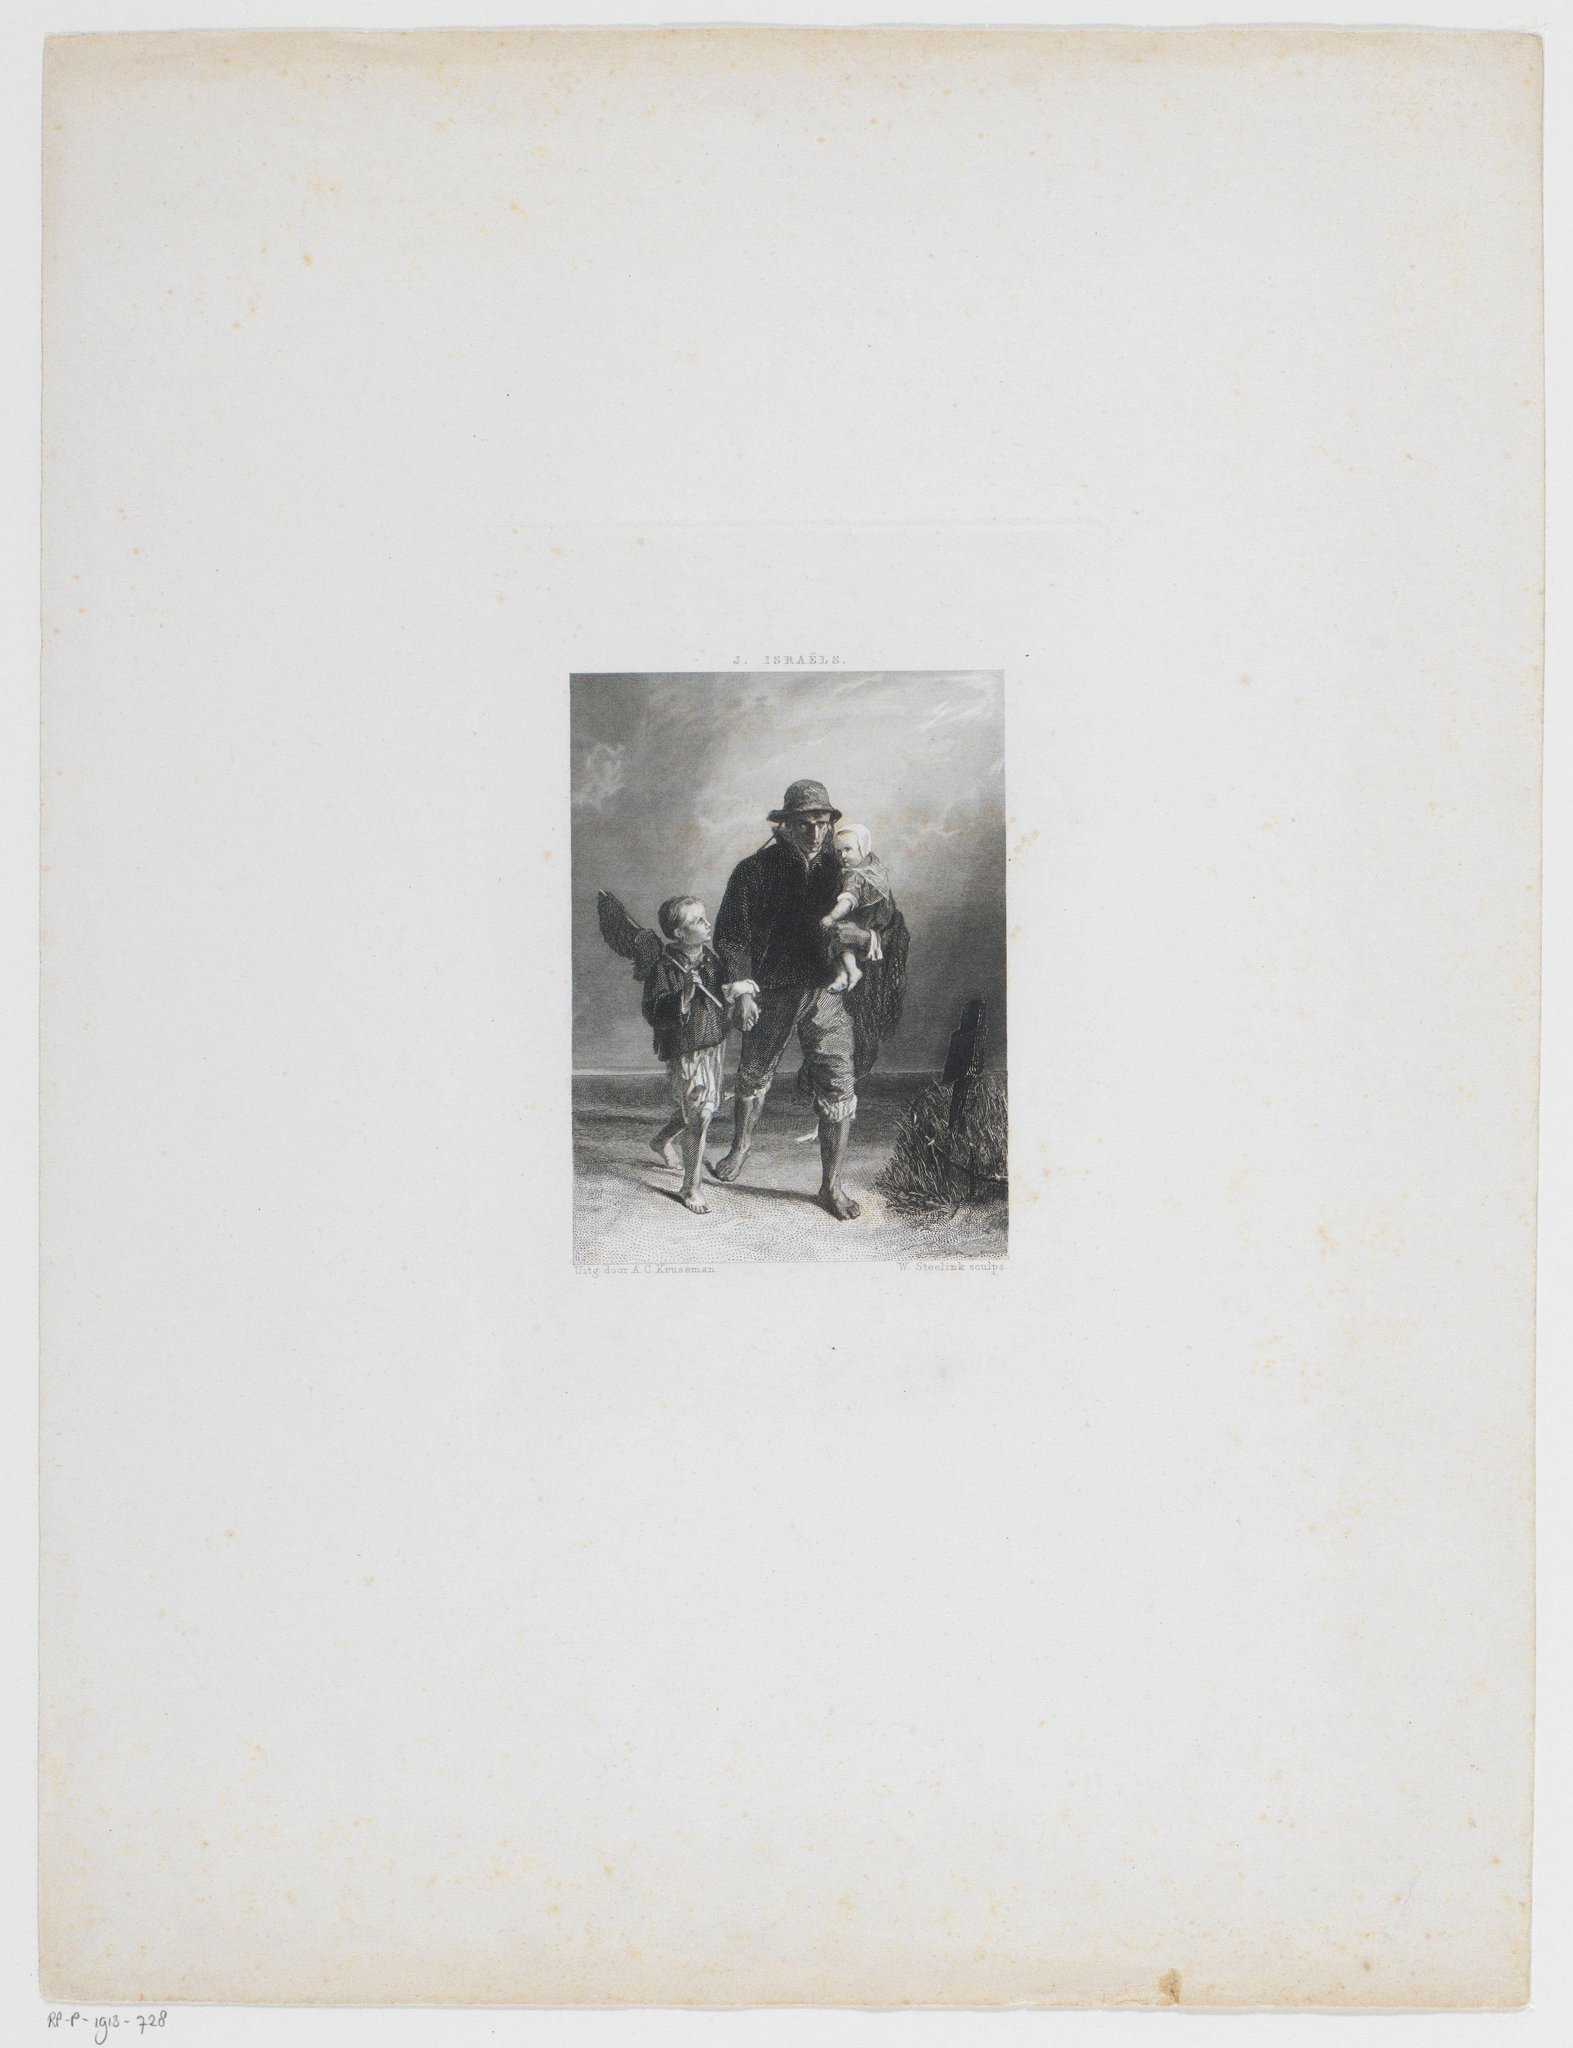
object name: book illustration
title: De gang langs het kerkhof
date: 1858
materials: paper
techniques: etching, engraving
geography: haarlem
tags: grave, tomb, widower, father and child(ren), man and child(ren) (family group)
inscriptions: collector's mark: Lugt 2233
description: Illustratie voor: Aurora. Jaarboekje voor 1858. Haarlem: Arie Cornelis Kruseman, 1858.